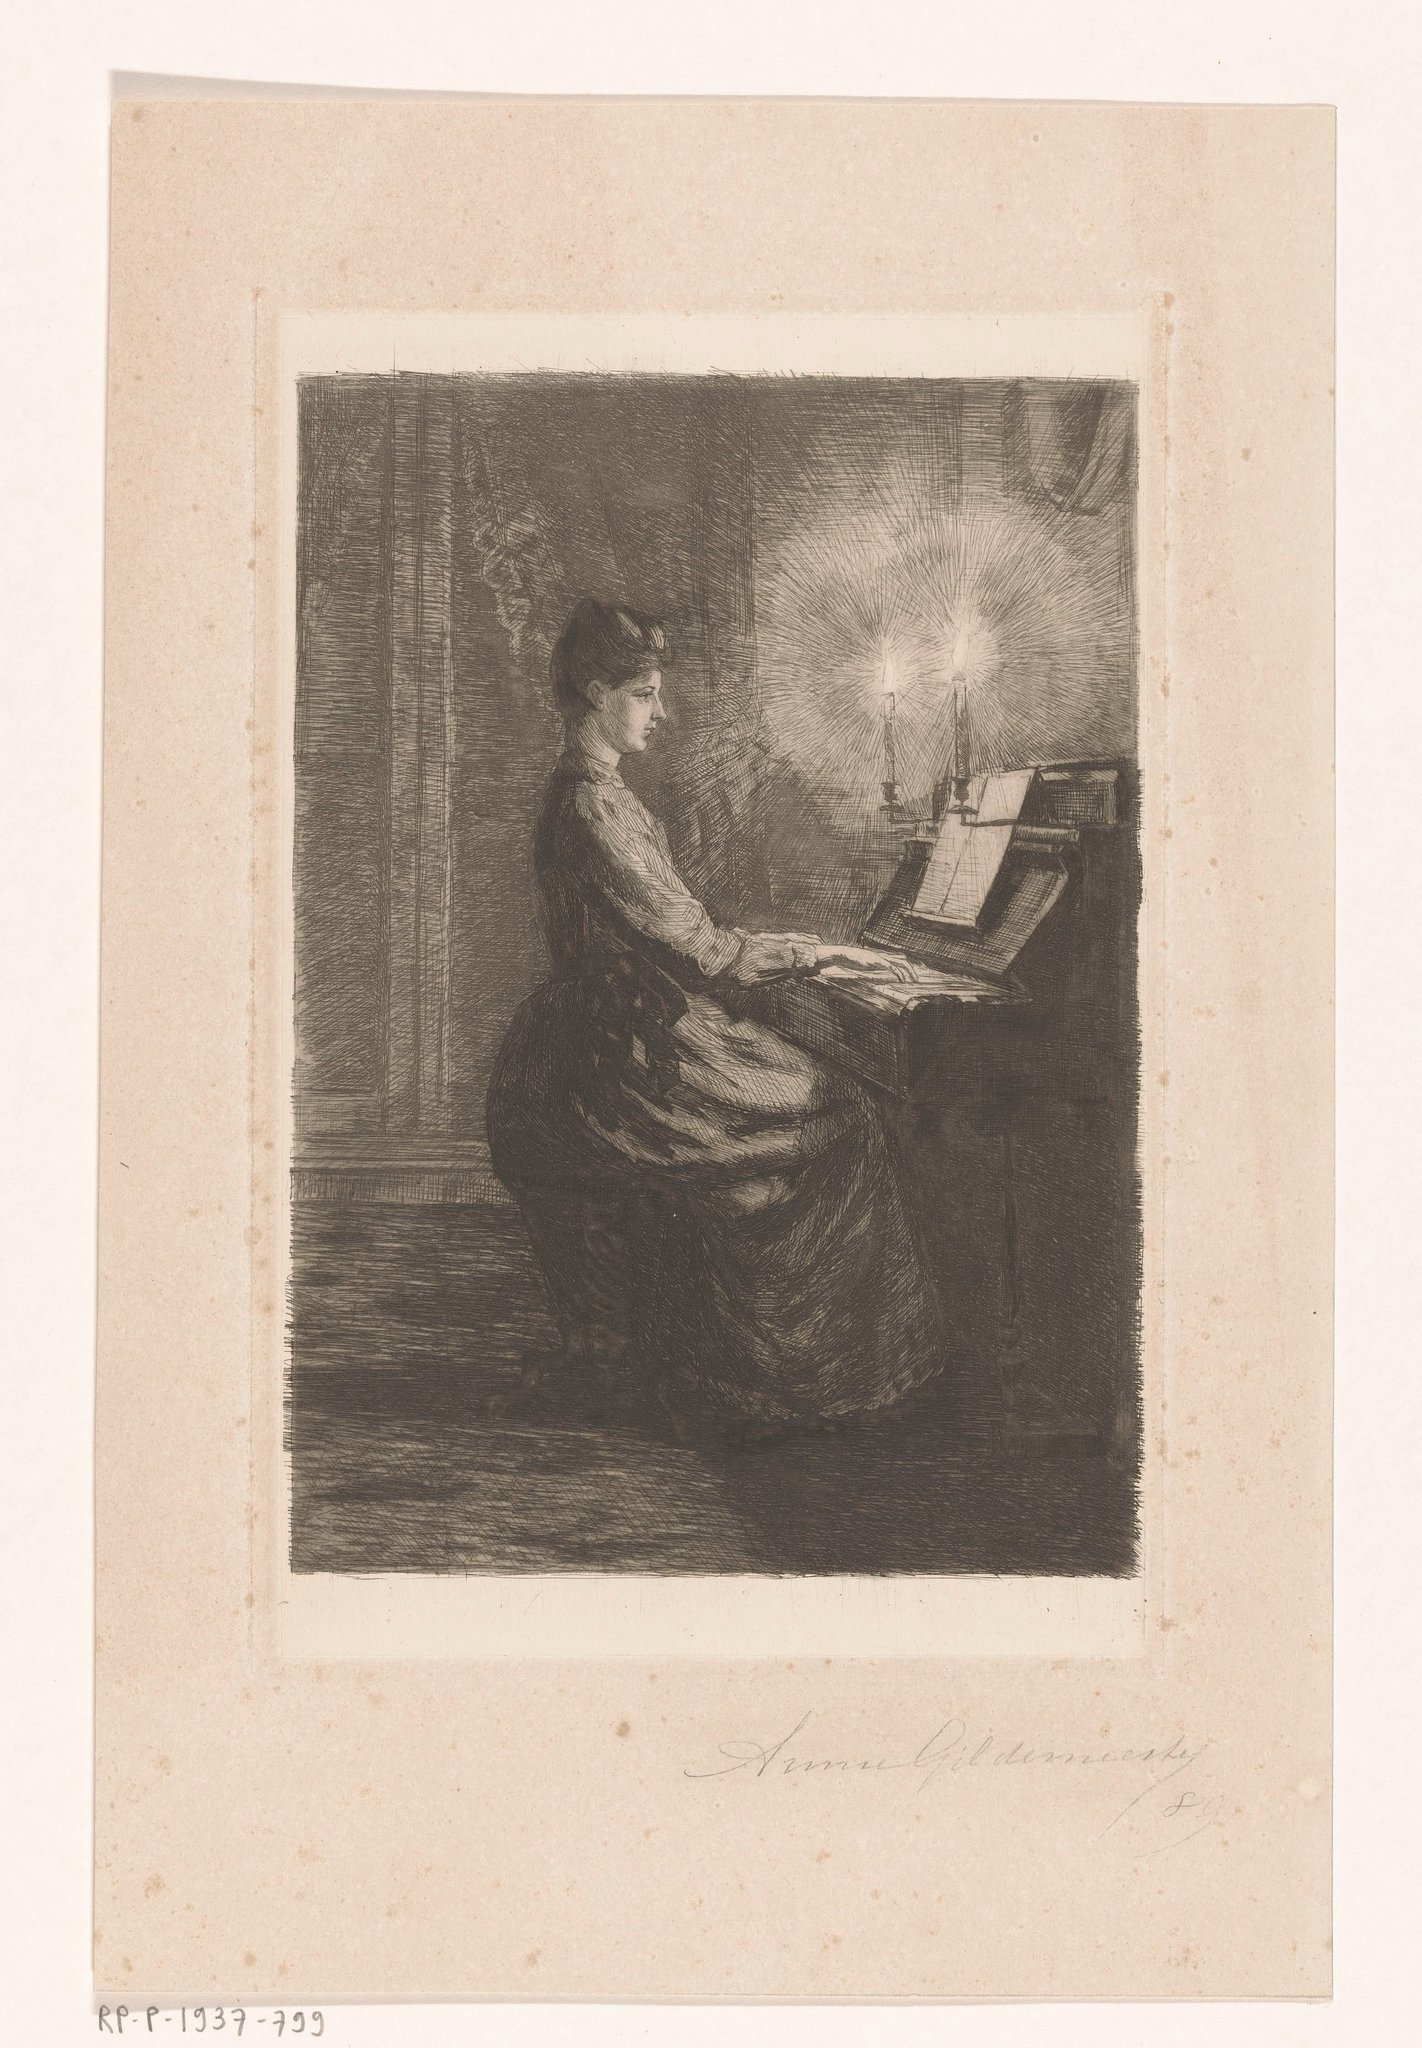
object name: print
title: Vrouw die een piano bespeelt bij kaarslicht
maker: anna gildemeester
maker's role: draughtsman, painter, print maker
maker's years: 1867-1945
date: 1889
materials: paper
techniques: aquatint, etching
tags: one person playing keyboard instrument, candle, clavichord, harpsichord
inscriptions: collector's mark: Lugt 2760, collector's mark: Lugt 2228